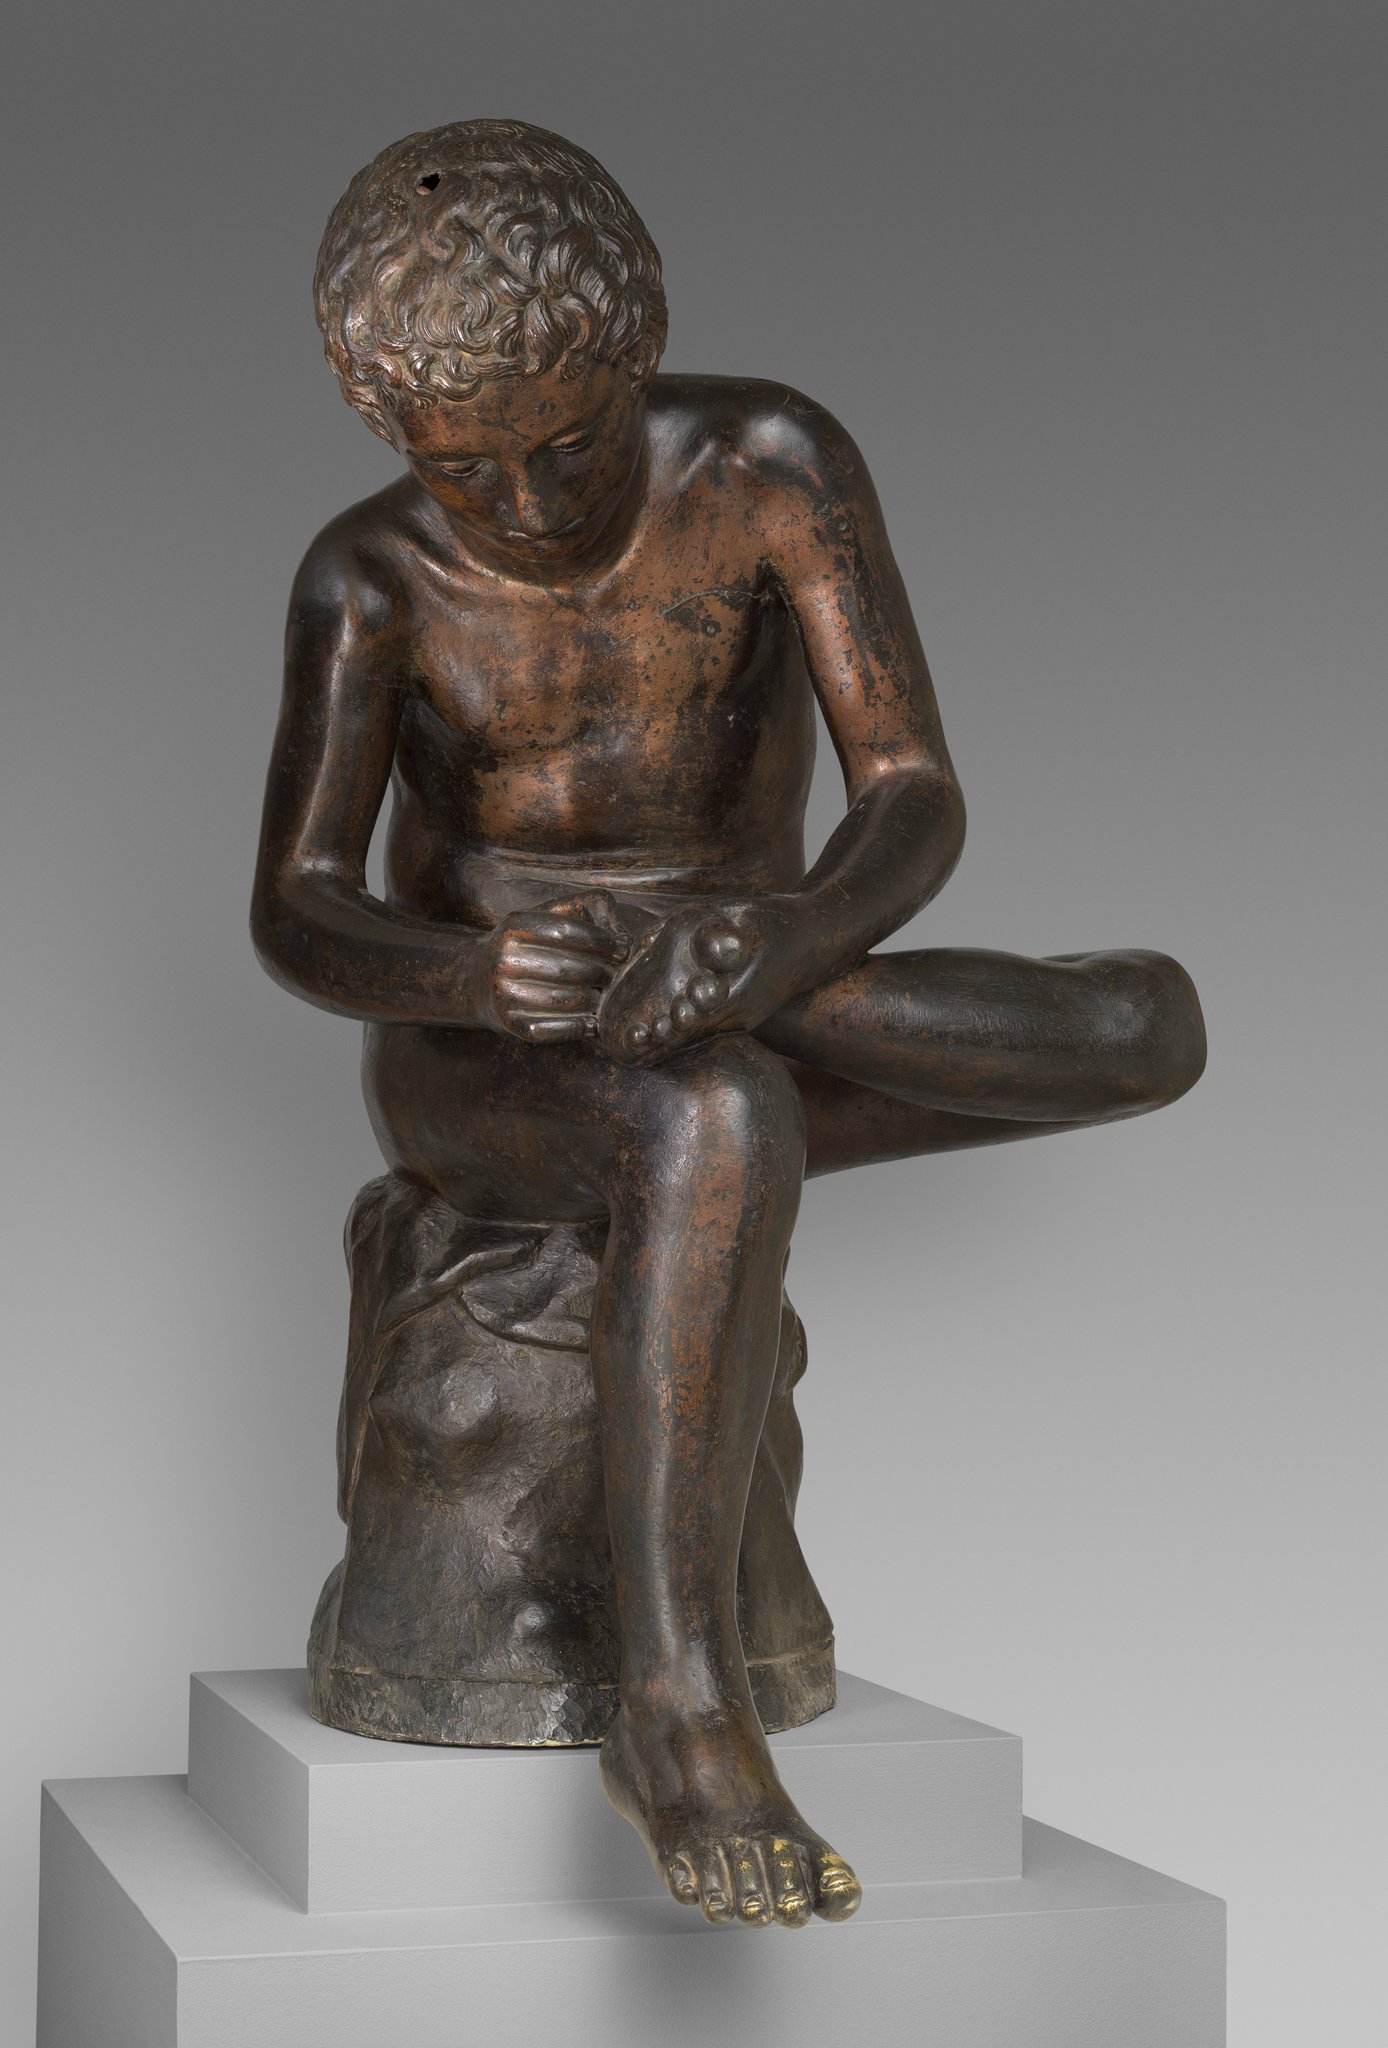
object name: statue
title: Spinario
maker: antonello gagini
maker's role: artist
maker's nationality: italian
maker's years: 1478-1536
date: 1501-1533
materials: bronze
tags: boys